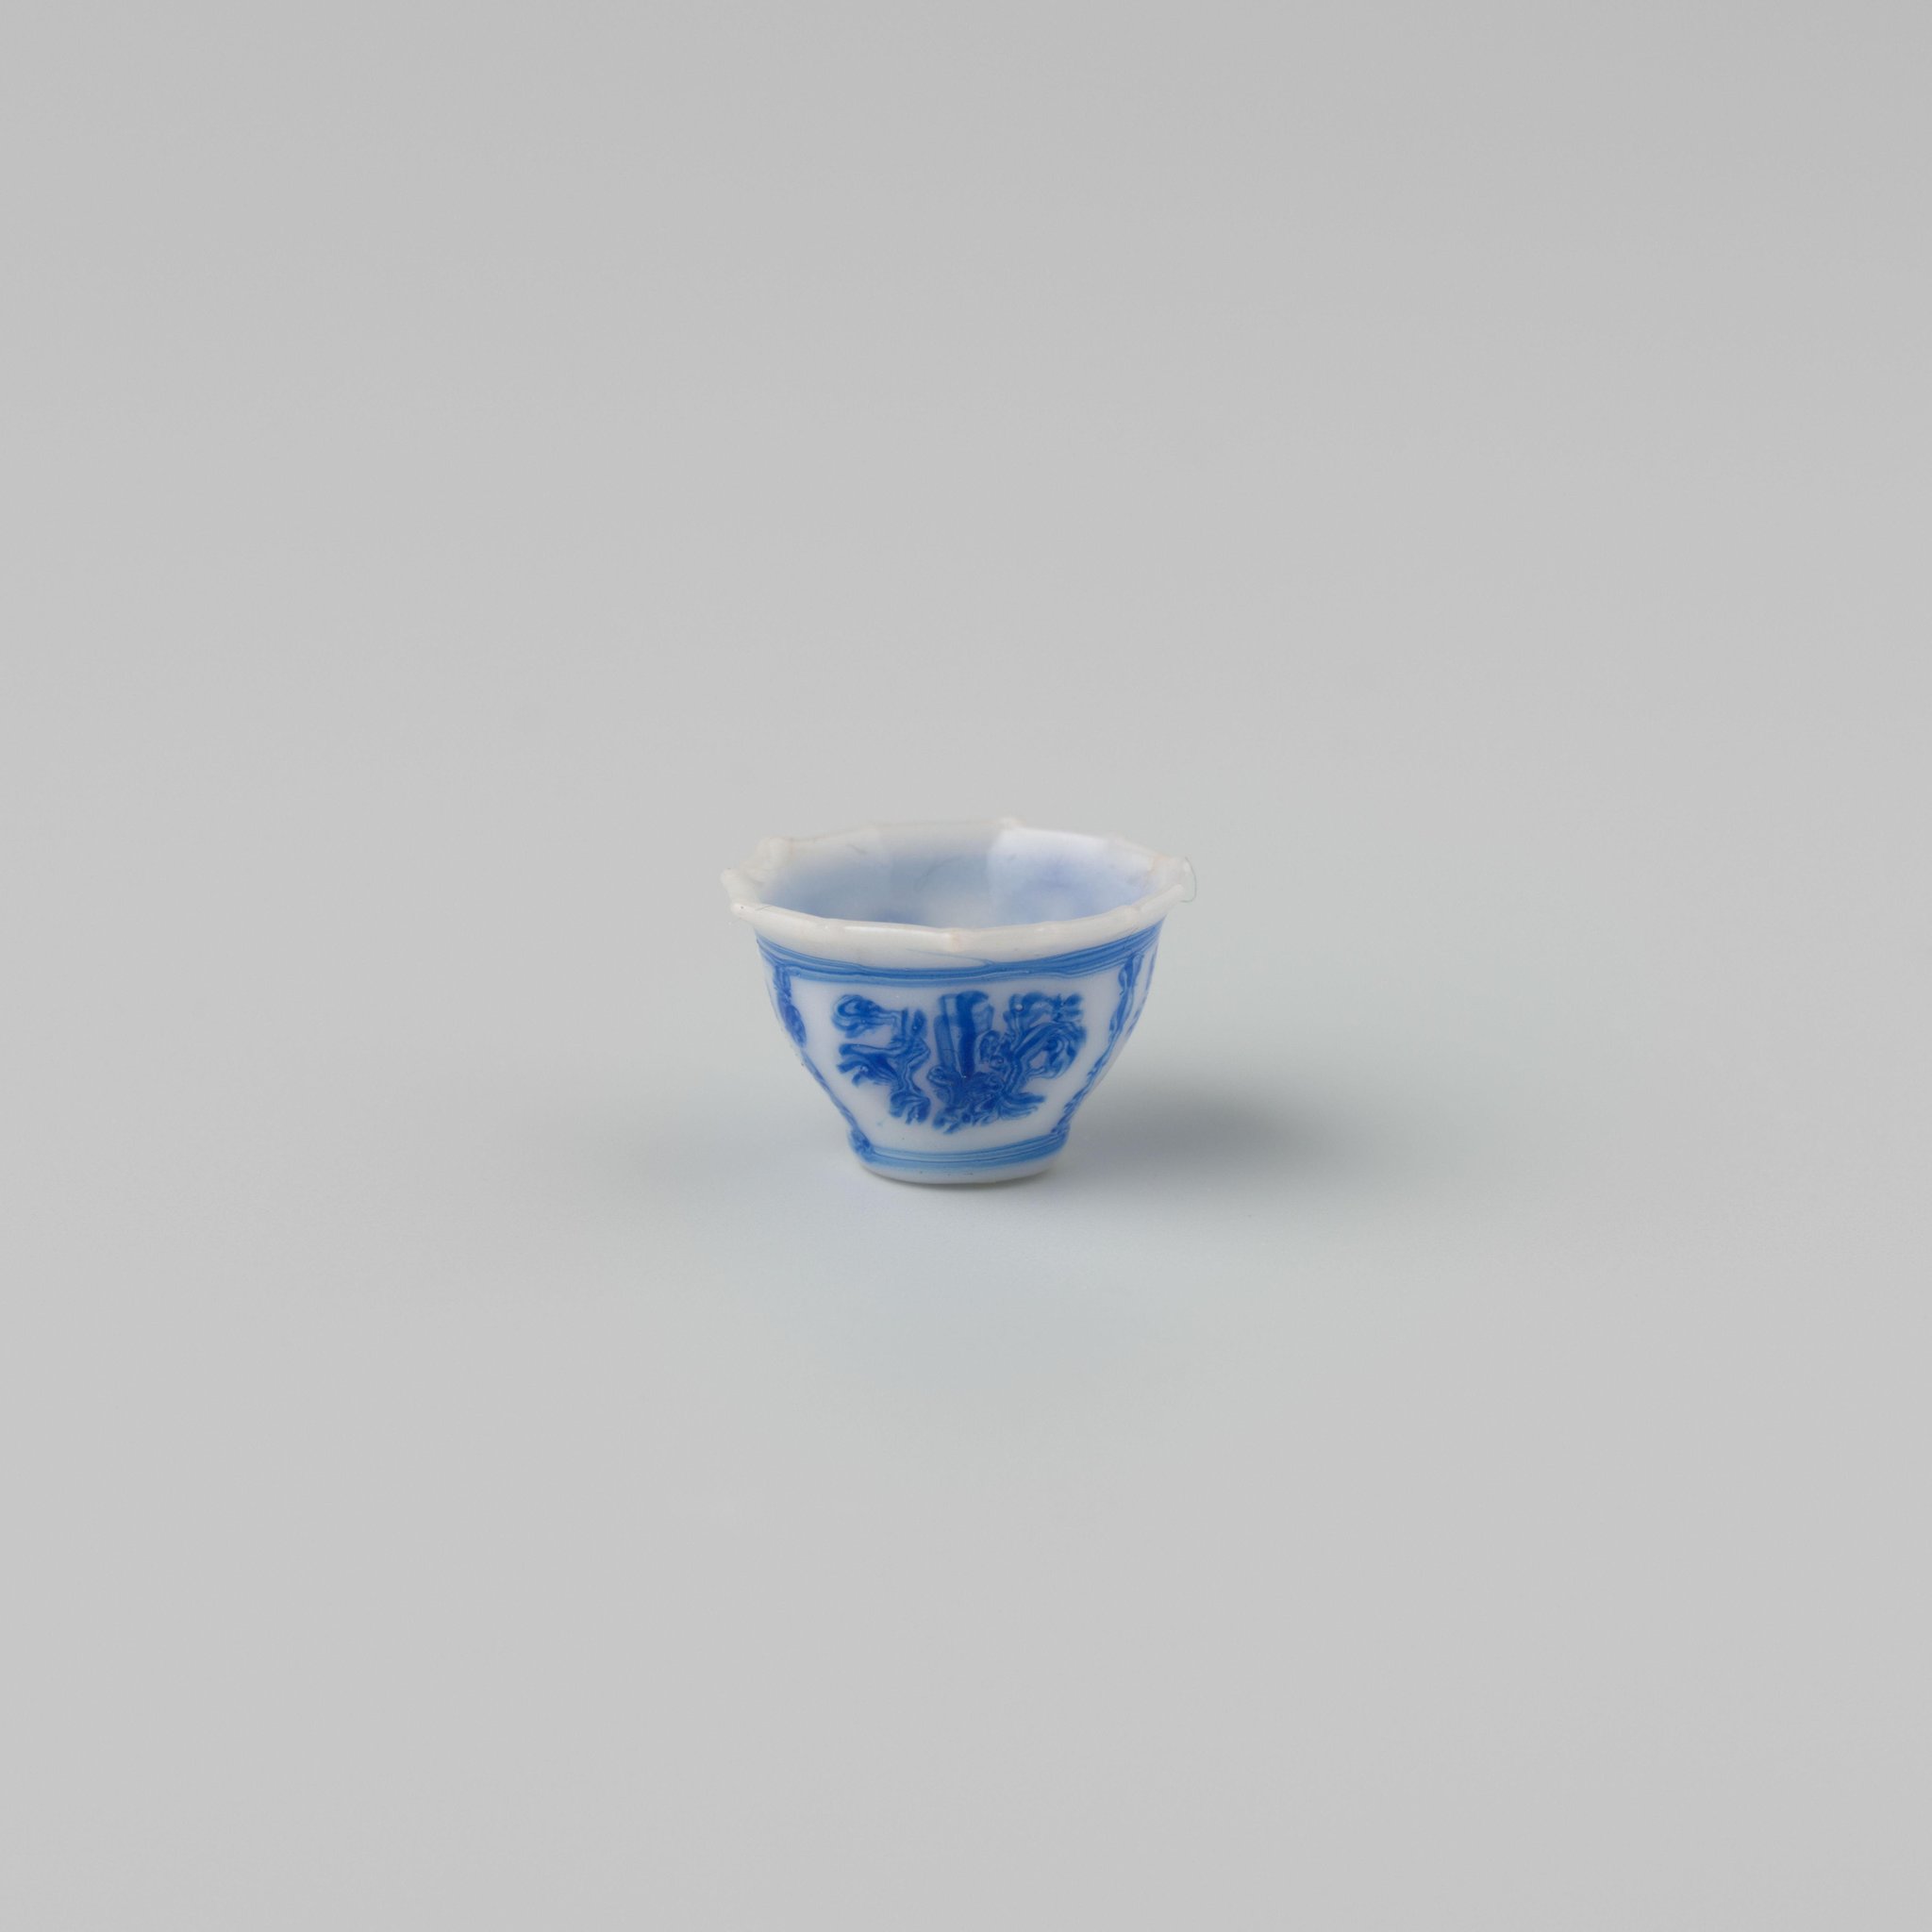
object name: cup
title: Theekopje van melkglas met blauwe emailverf beschildering, imitatie Chinees porselein met 'bloem' decoratie in drie vakken; model met puntrand, nauwelijks een standring.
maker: Anonymous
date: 1675-1710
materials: glass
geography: amsterdam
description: Theekopje van melkglas met blauwe email verf beschildering, imitatie Chinees porselein met bloem versiering in drie vakken; model met puntrand, nauwelijks een standring.